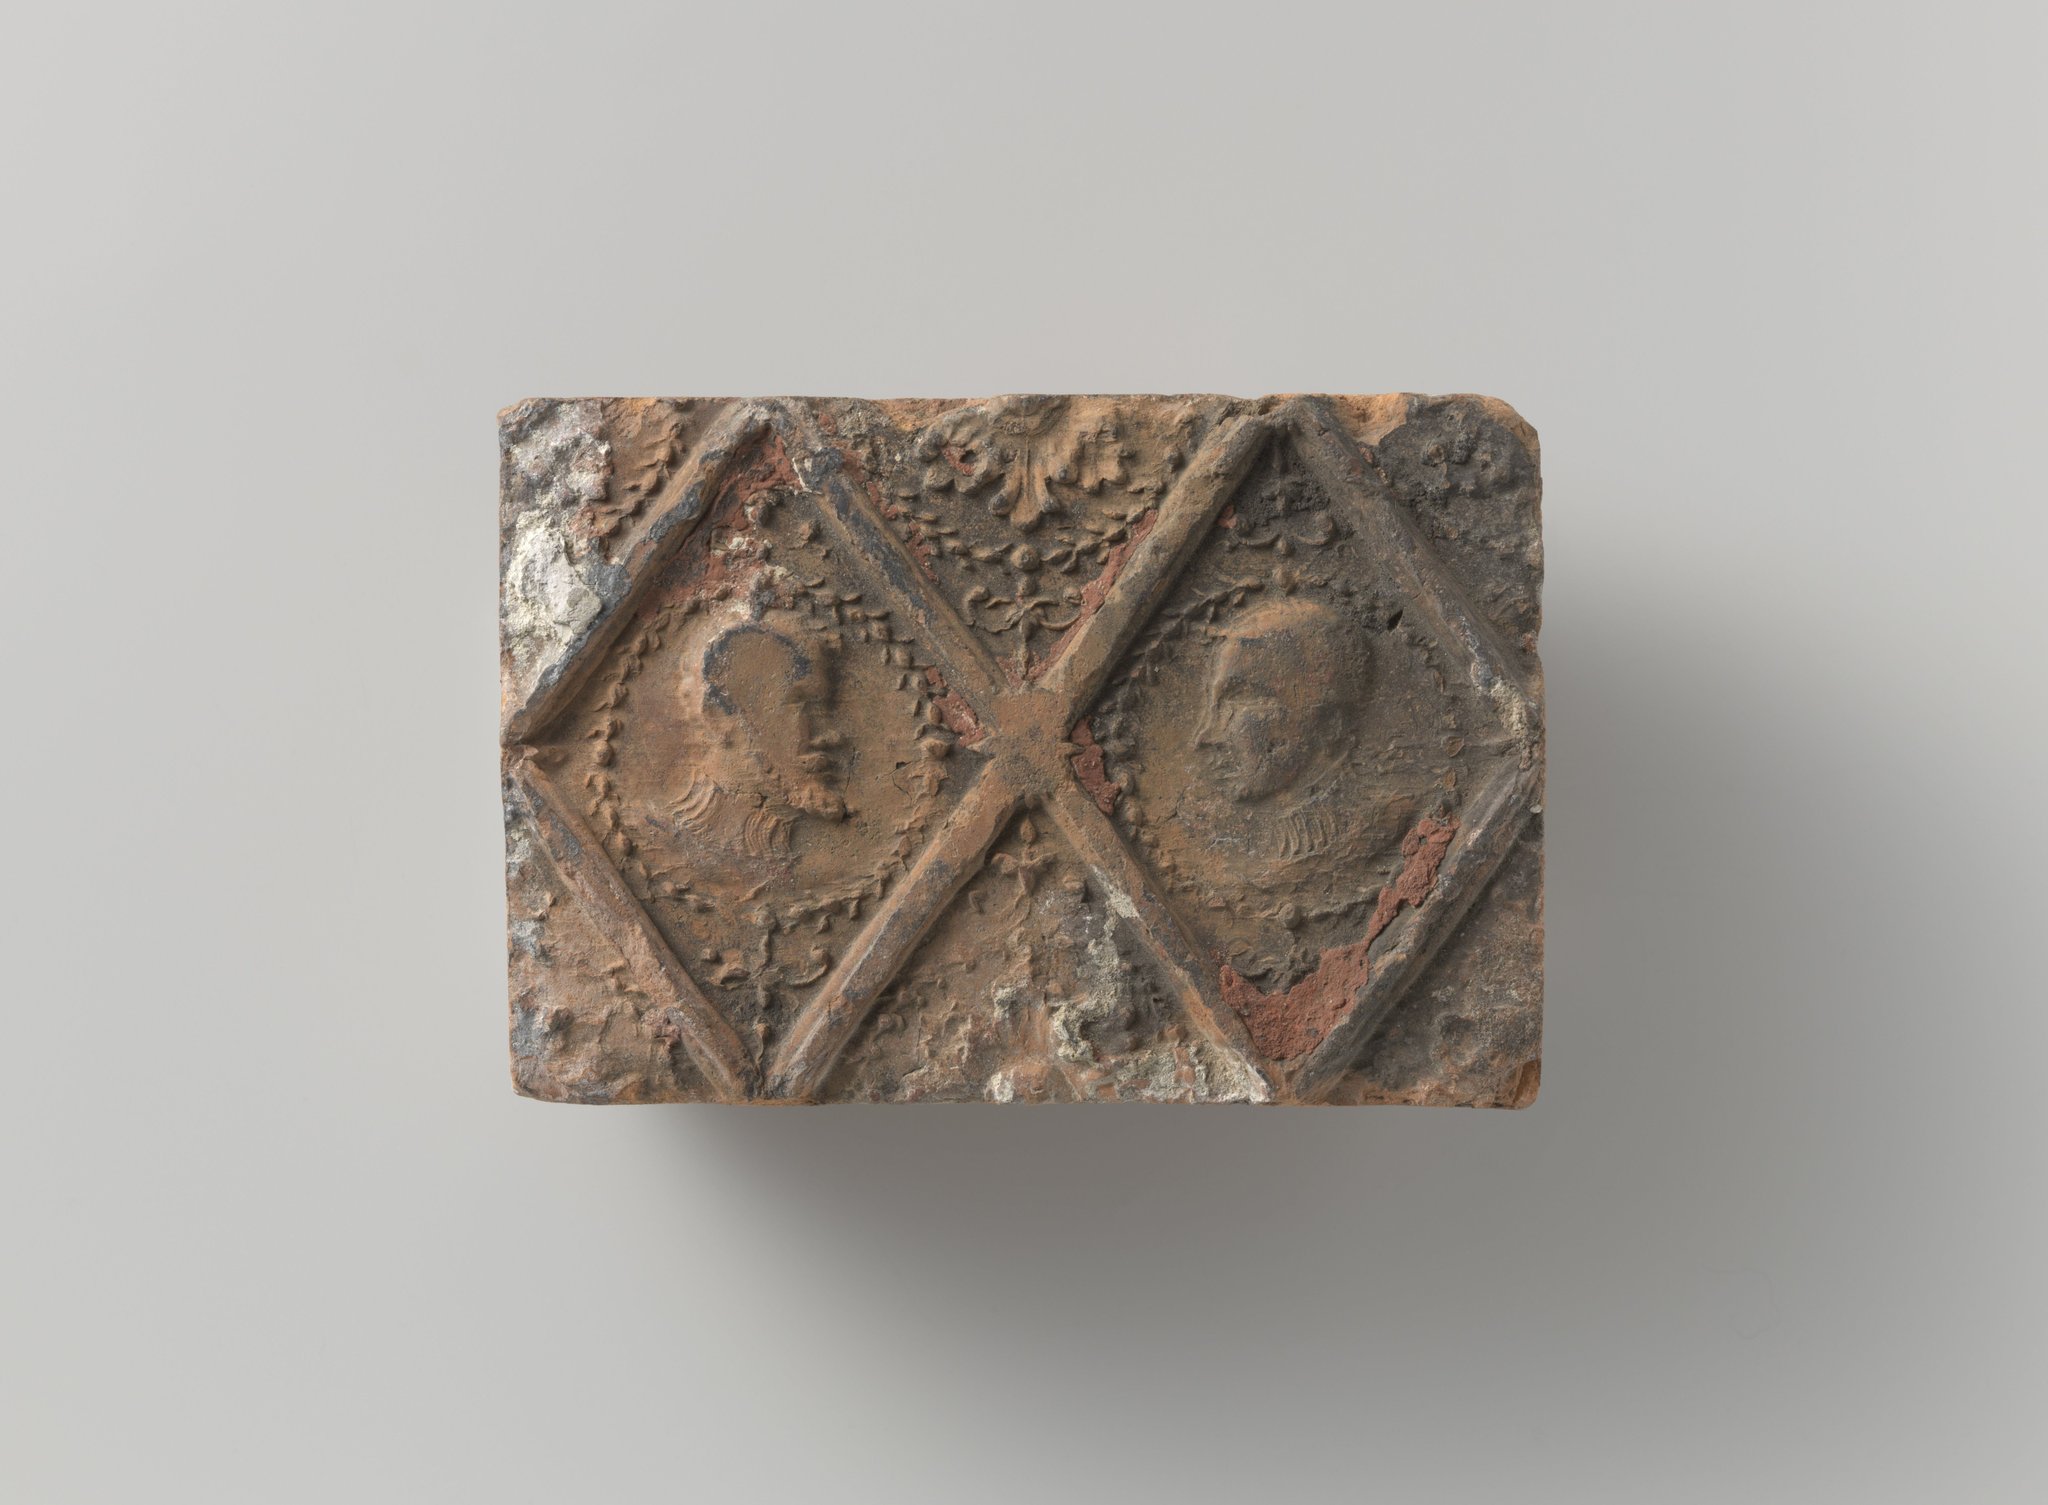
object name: hearthstone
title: Haardsteen met een voorstelling van twee manskoppen in ruiten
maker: Anonymous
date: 1499-1699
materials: earthenware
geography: southern netherlands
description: Haardsteen met een voorstelling van twee manskoppen in ruiten